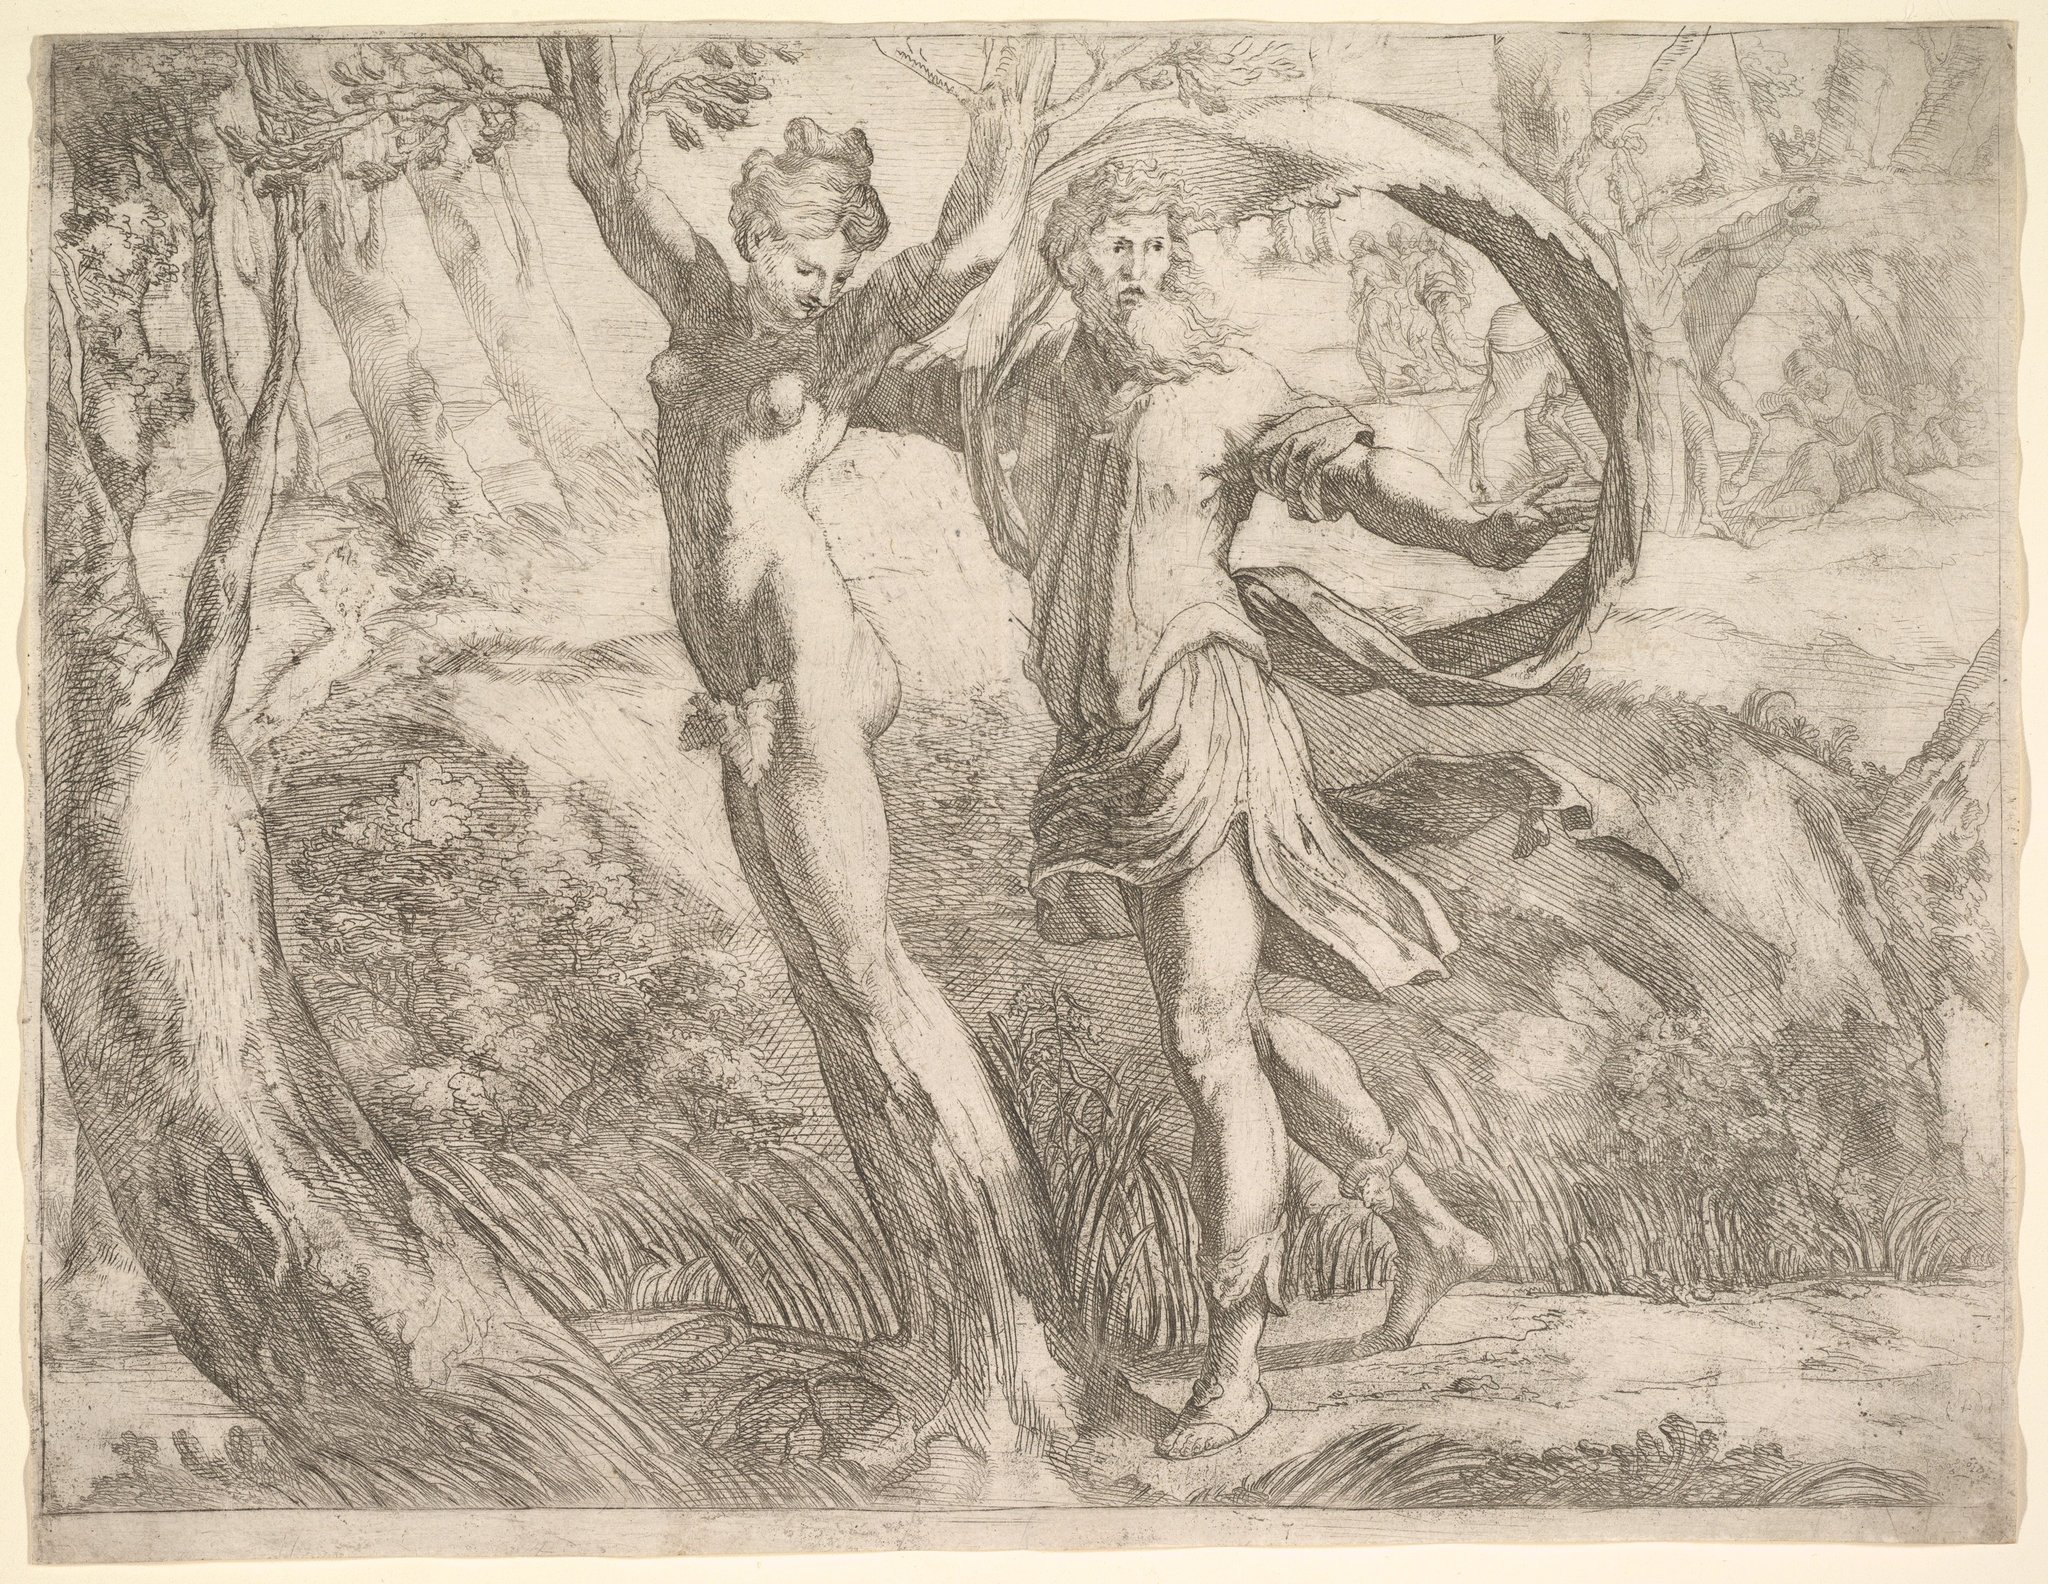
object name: print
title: Wilton Album, folio 10a: Priapus and Lotis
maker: anonymous, italian, 16th century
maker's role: artist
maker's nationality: italian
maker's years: 1500-1600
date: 1530-1550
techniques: etching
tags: men,female nudes